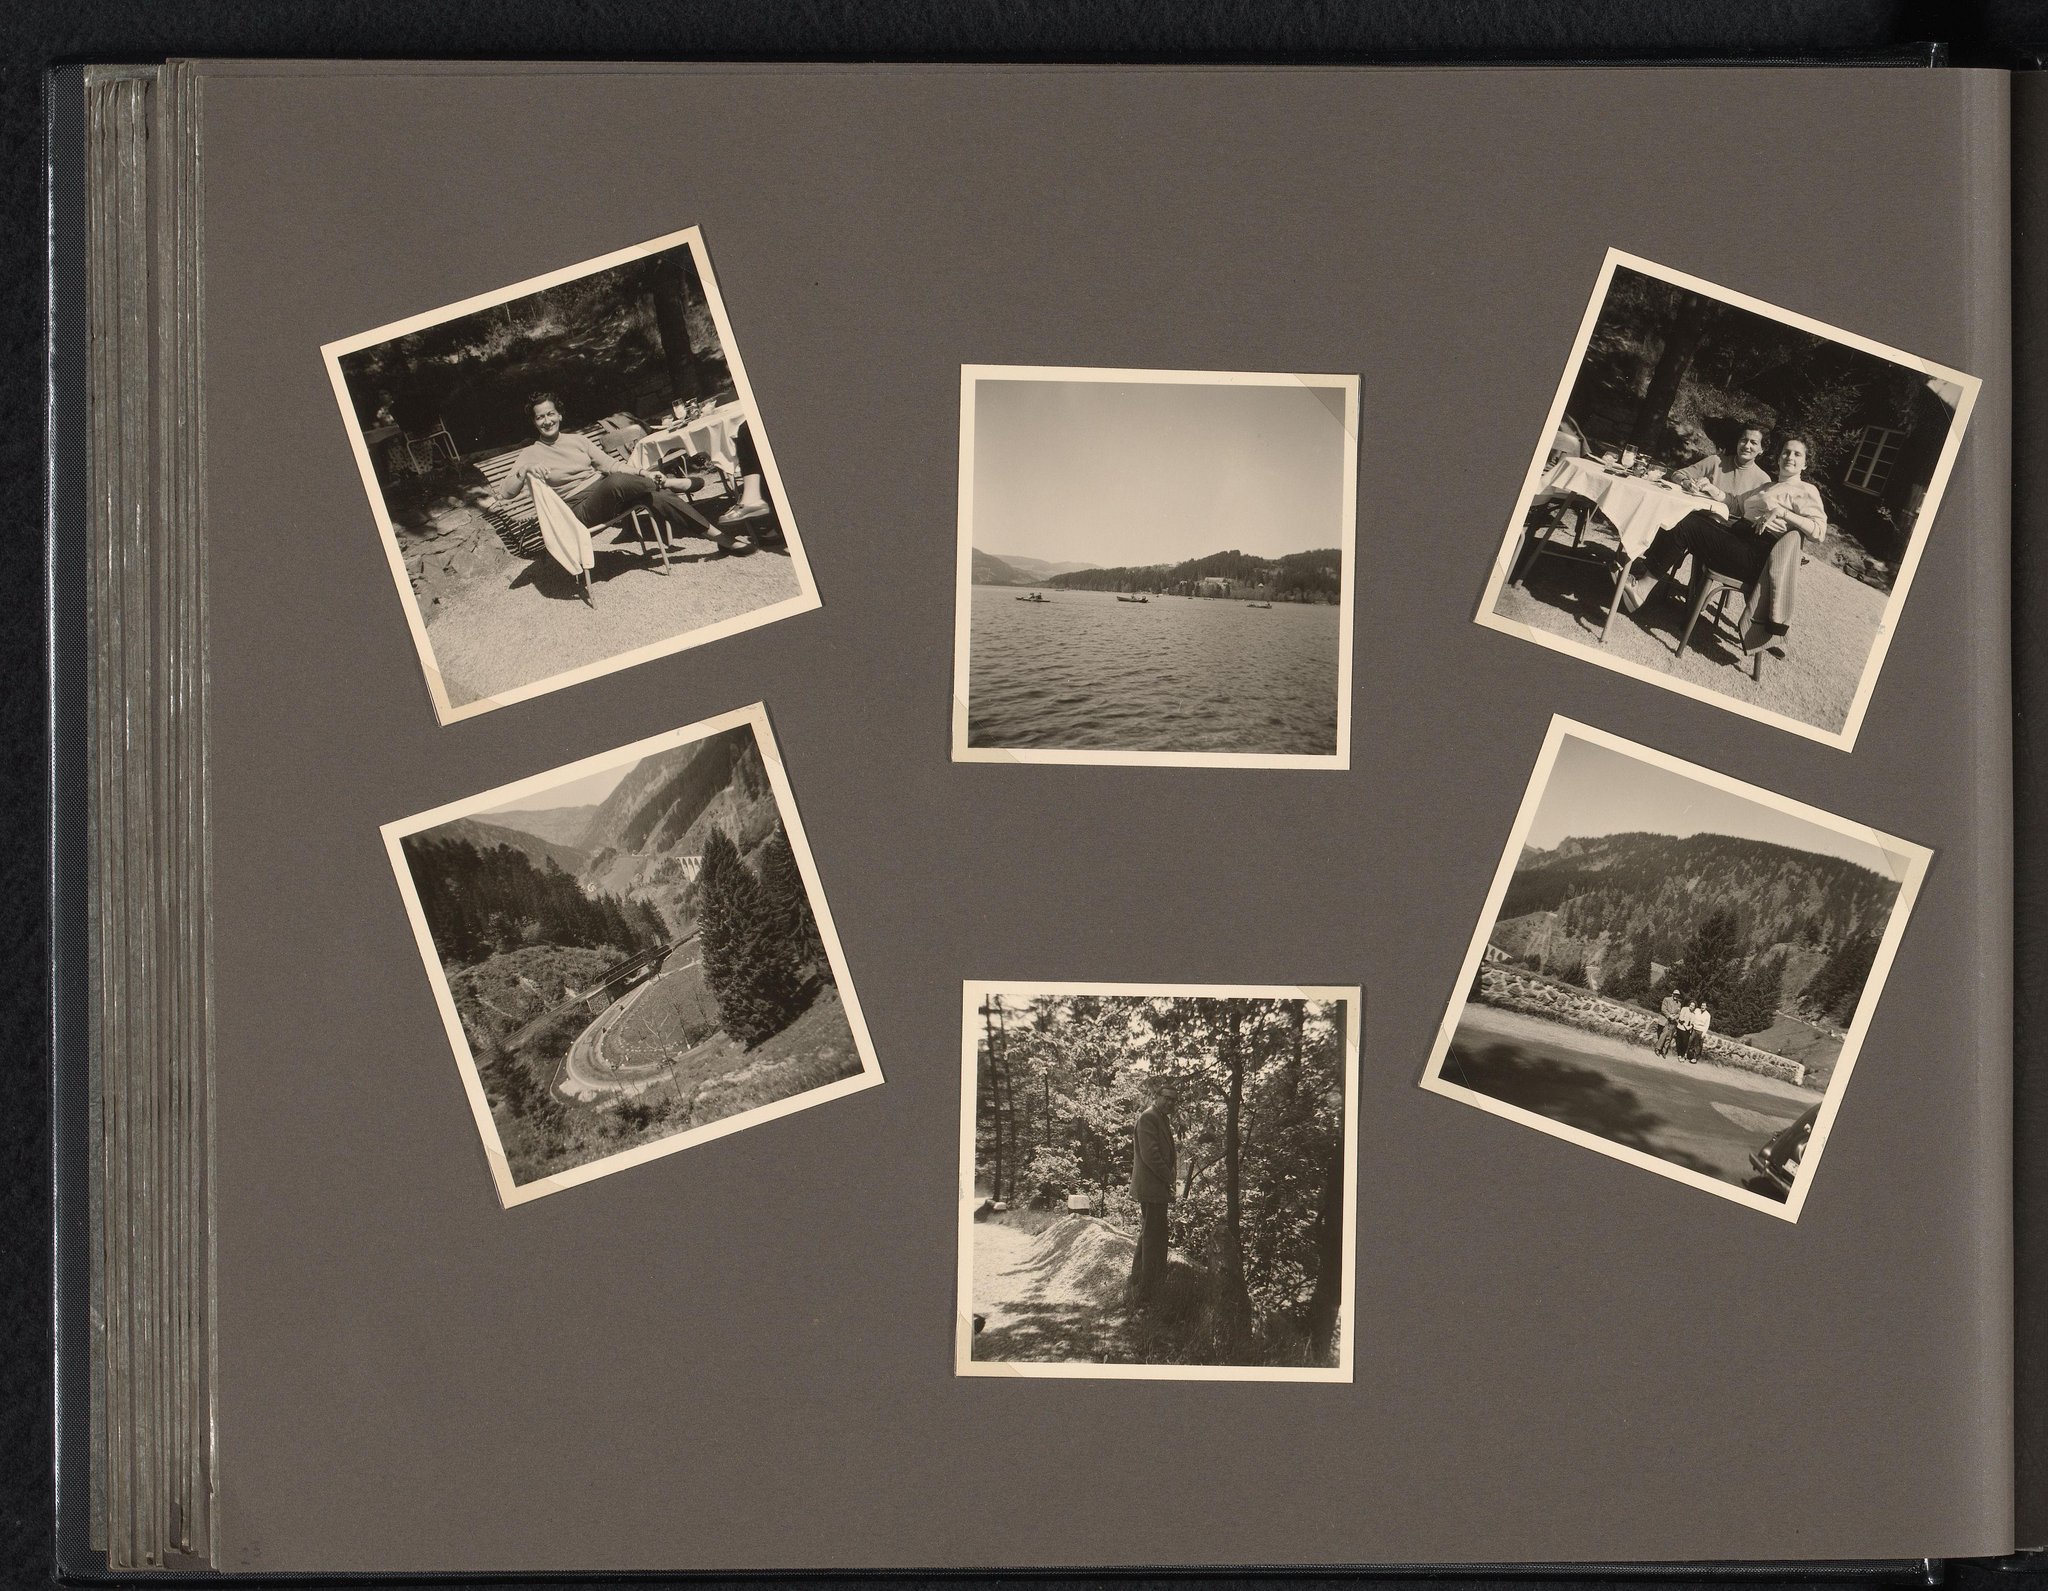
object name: photograph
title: Isabel Wachenheimer en haar derde echtgenoot Gideon Elon in de bergen met een echtpaar, mogelijk in Duitsland of de Verenigde Staten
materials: paper, cardboard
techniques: gelatin silver print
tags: leiden, isabel wachenheimer-elon, gideon elon, forest, wood, mountains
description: Blad bevat zes foto's van Isabel Wachenheimer en Gideon Elon en twee andere mensen. Deze foto's maken deel uit van een album.